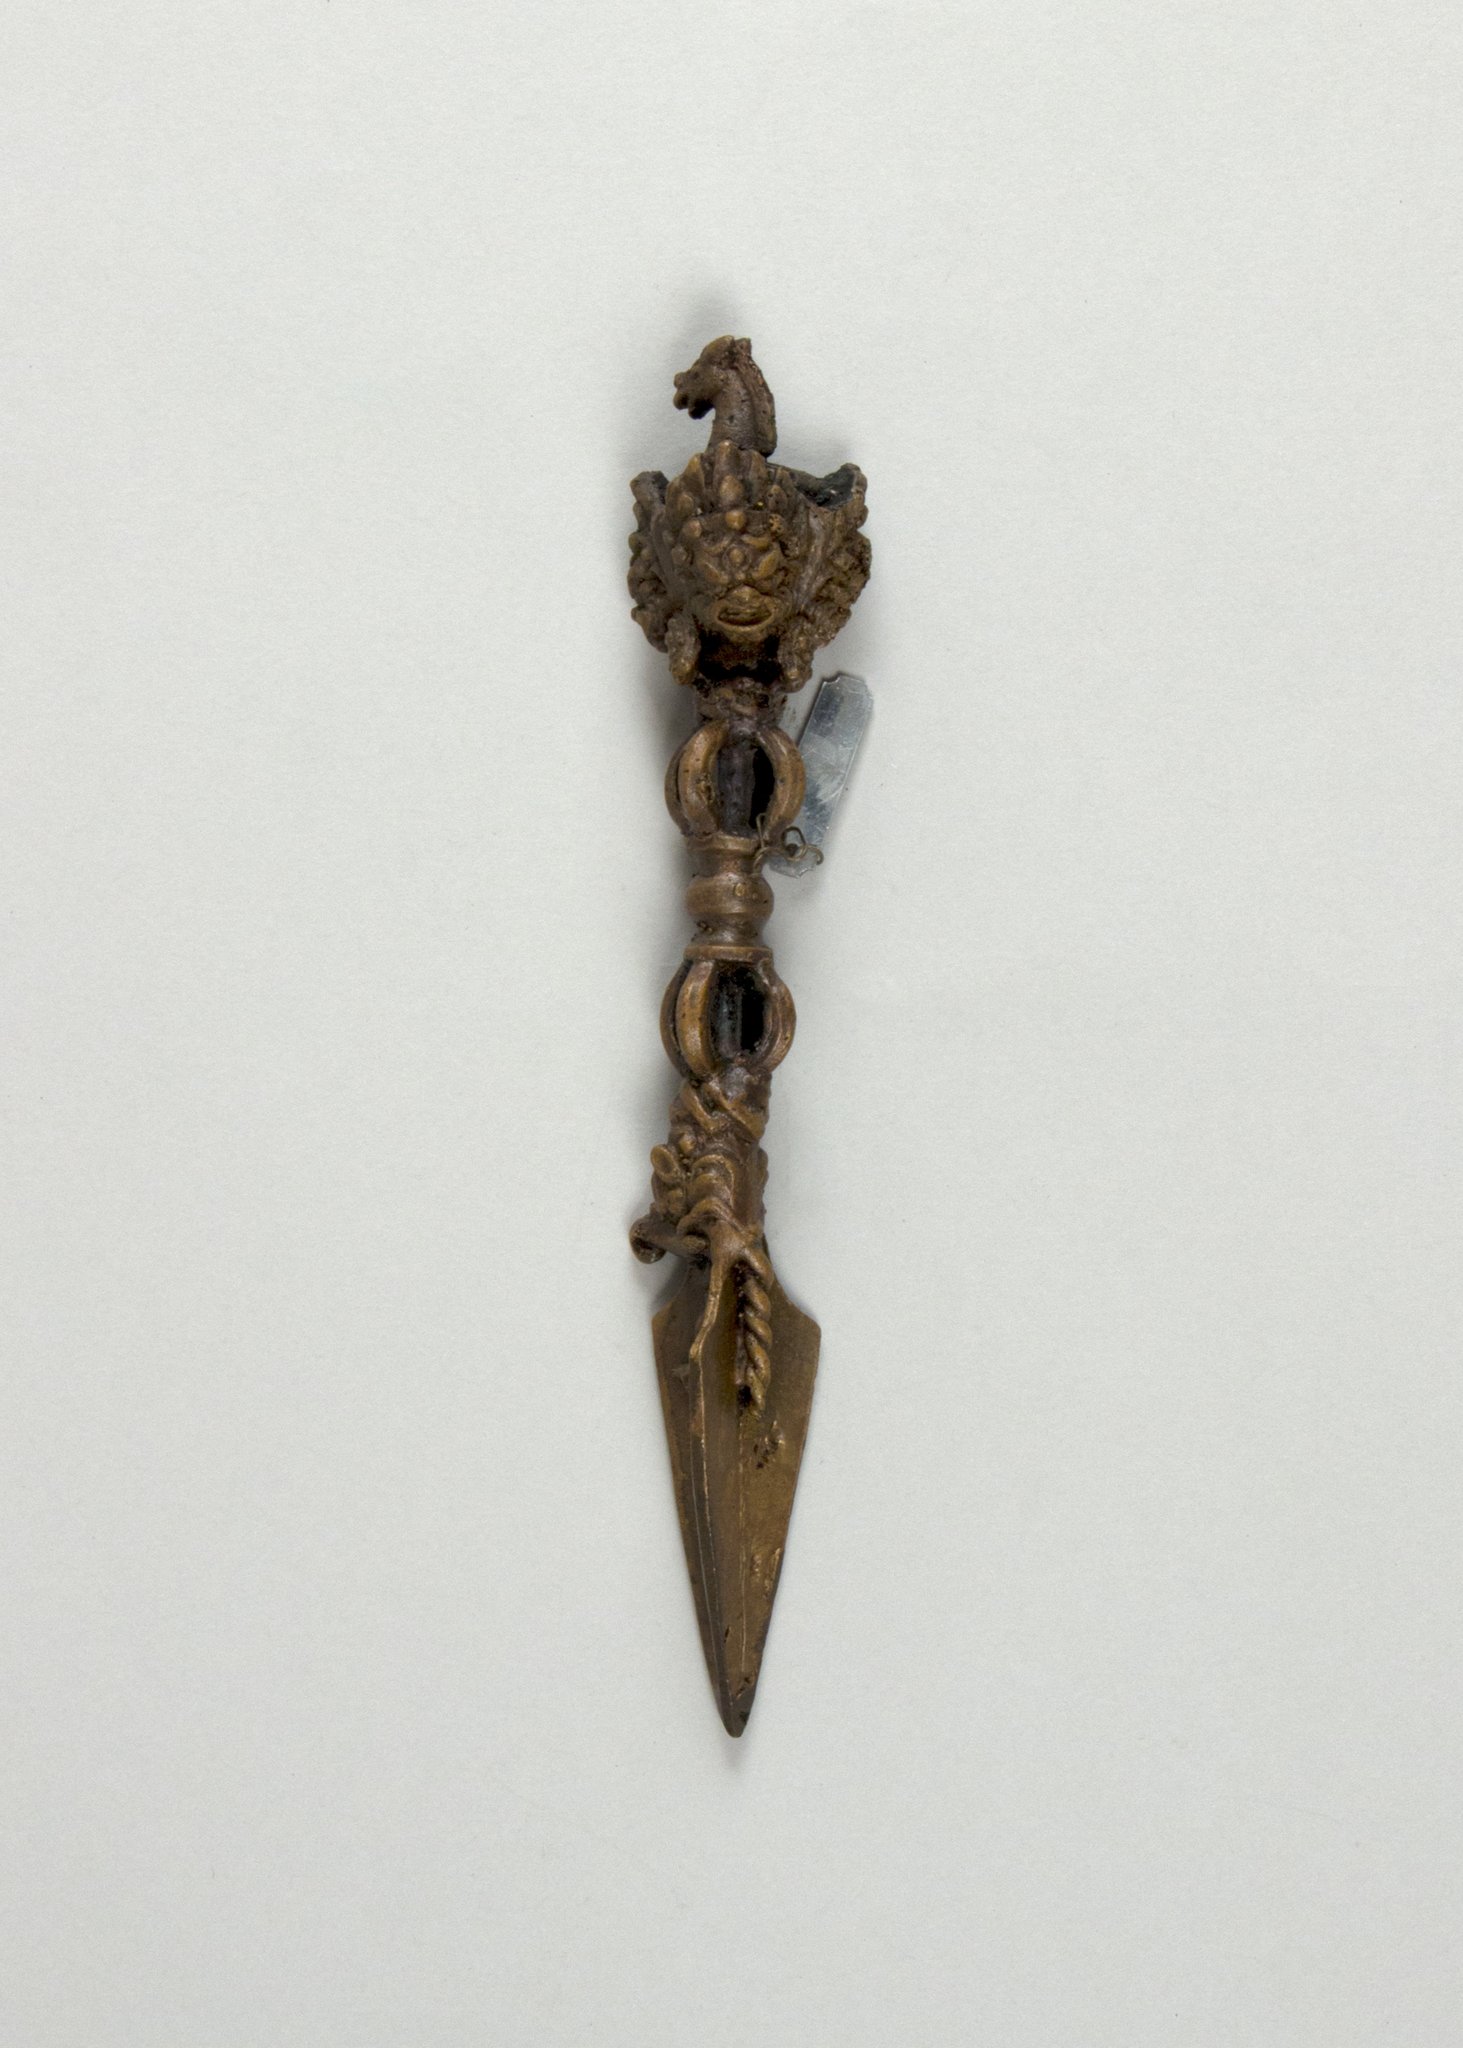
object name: ritual dagger phur pa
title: Ritual Dagger (Phur Pa)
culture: tibetan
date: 1801-1900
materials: brass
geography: tibet